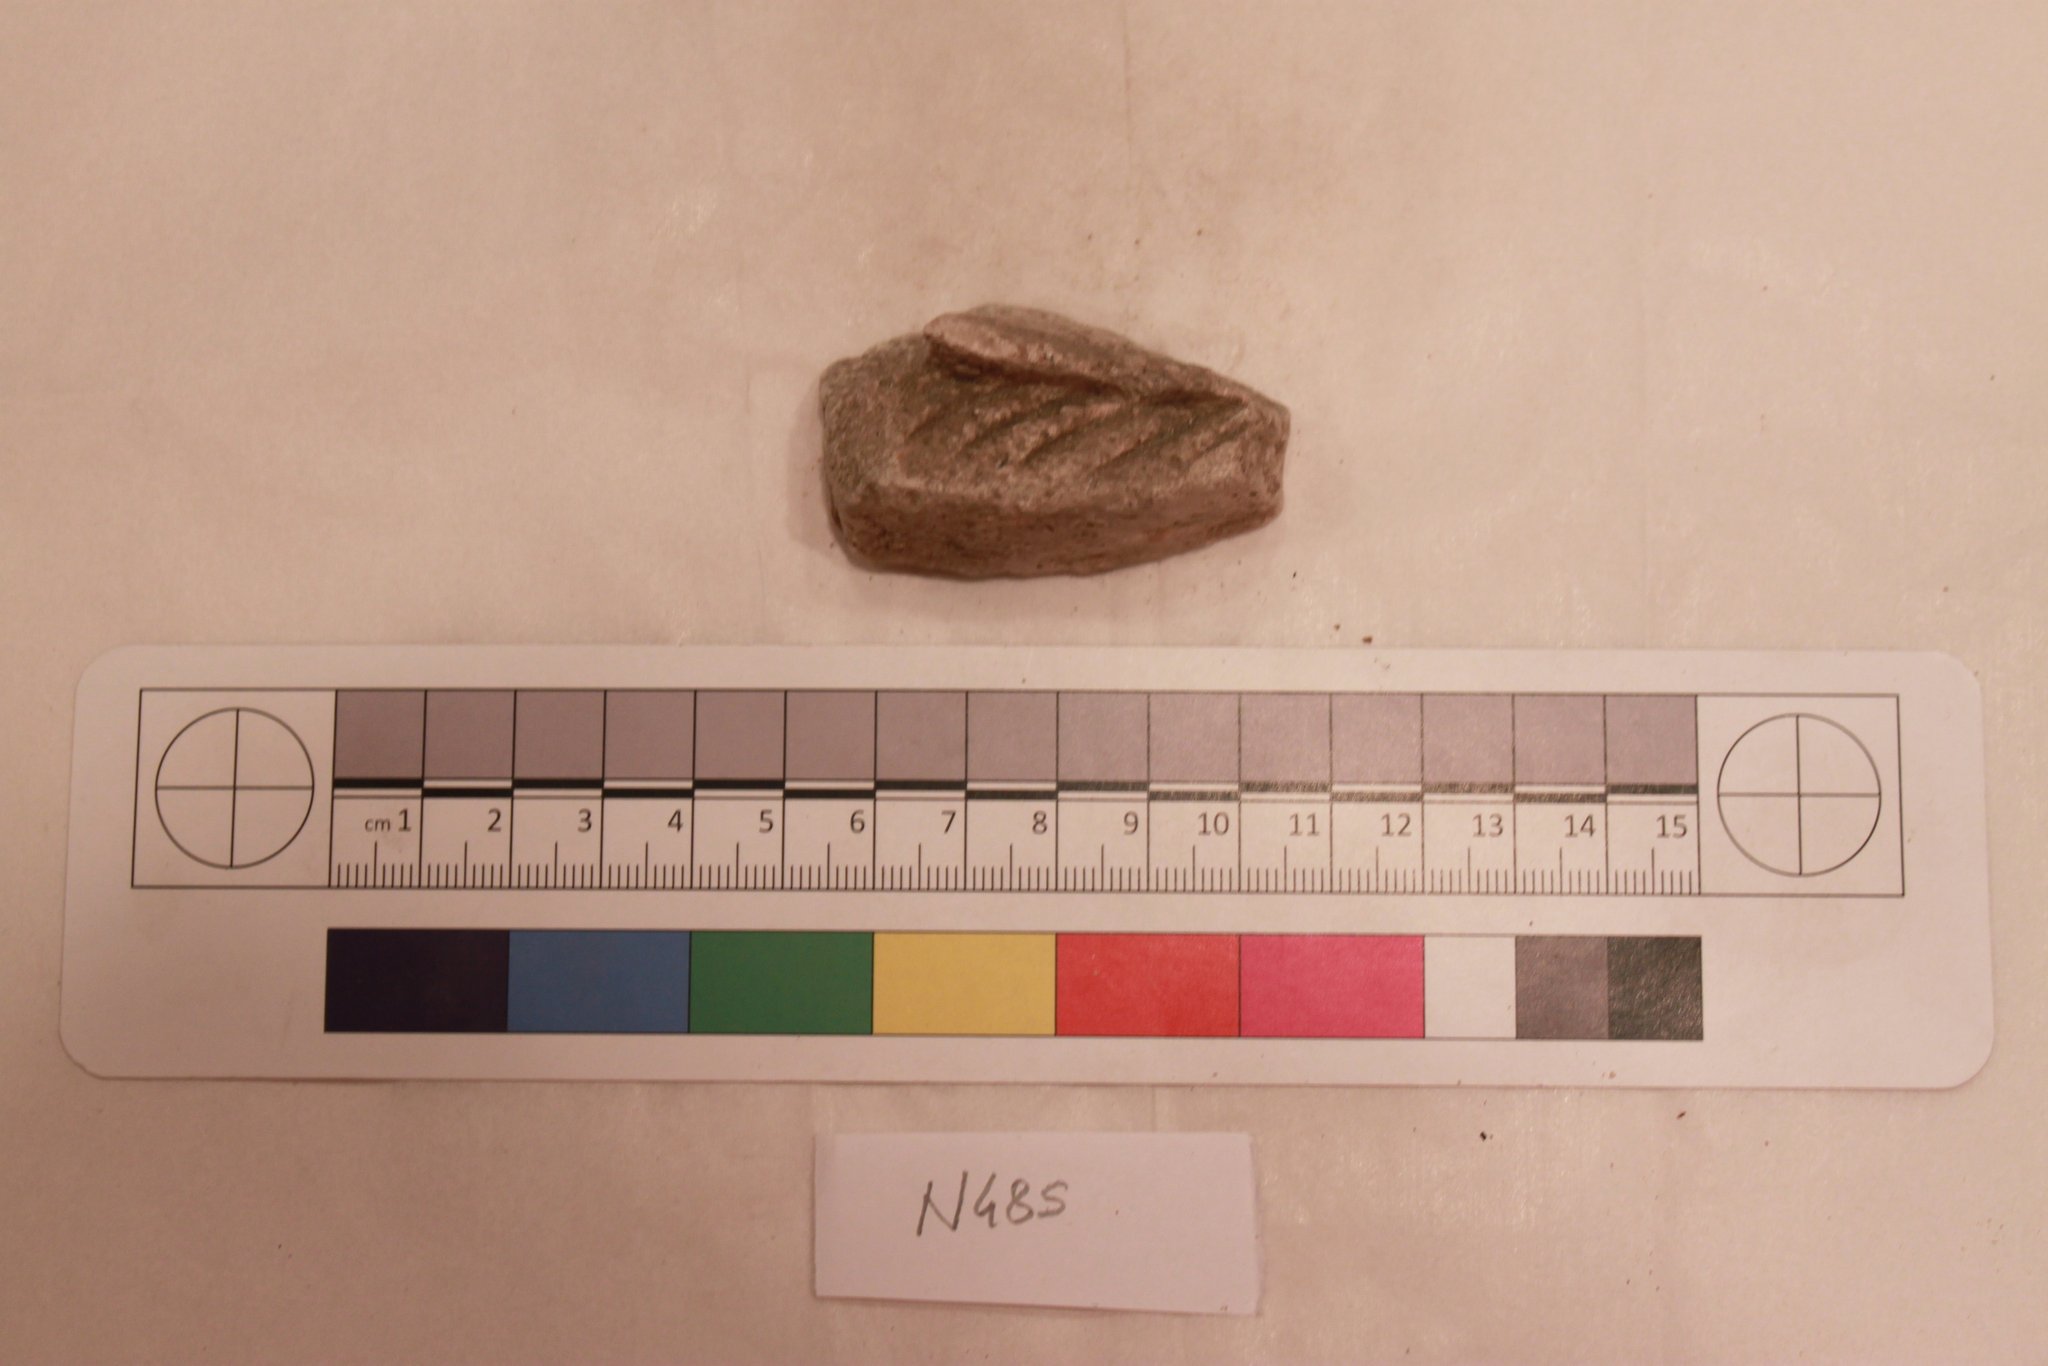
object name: fragment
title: Stucco Fragment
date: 701-1200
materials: plaster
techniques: carving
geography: iran